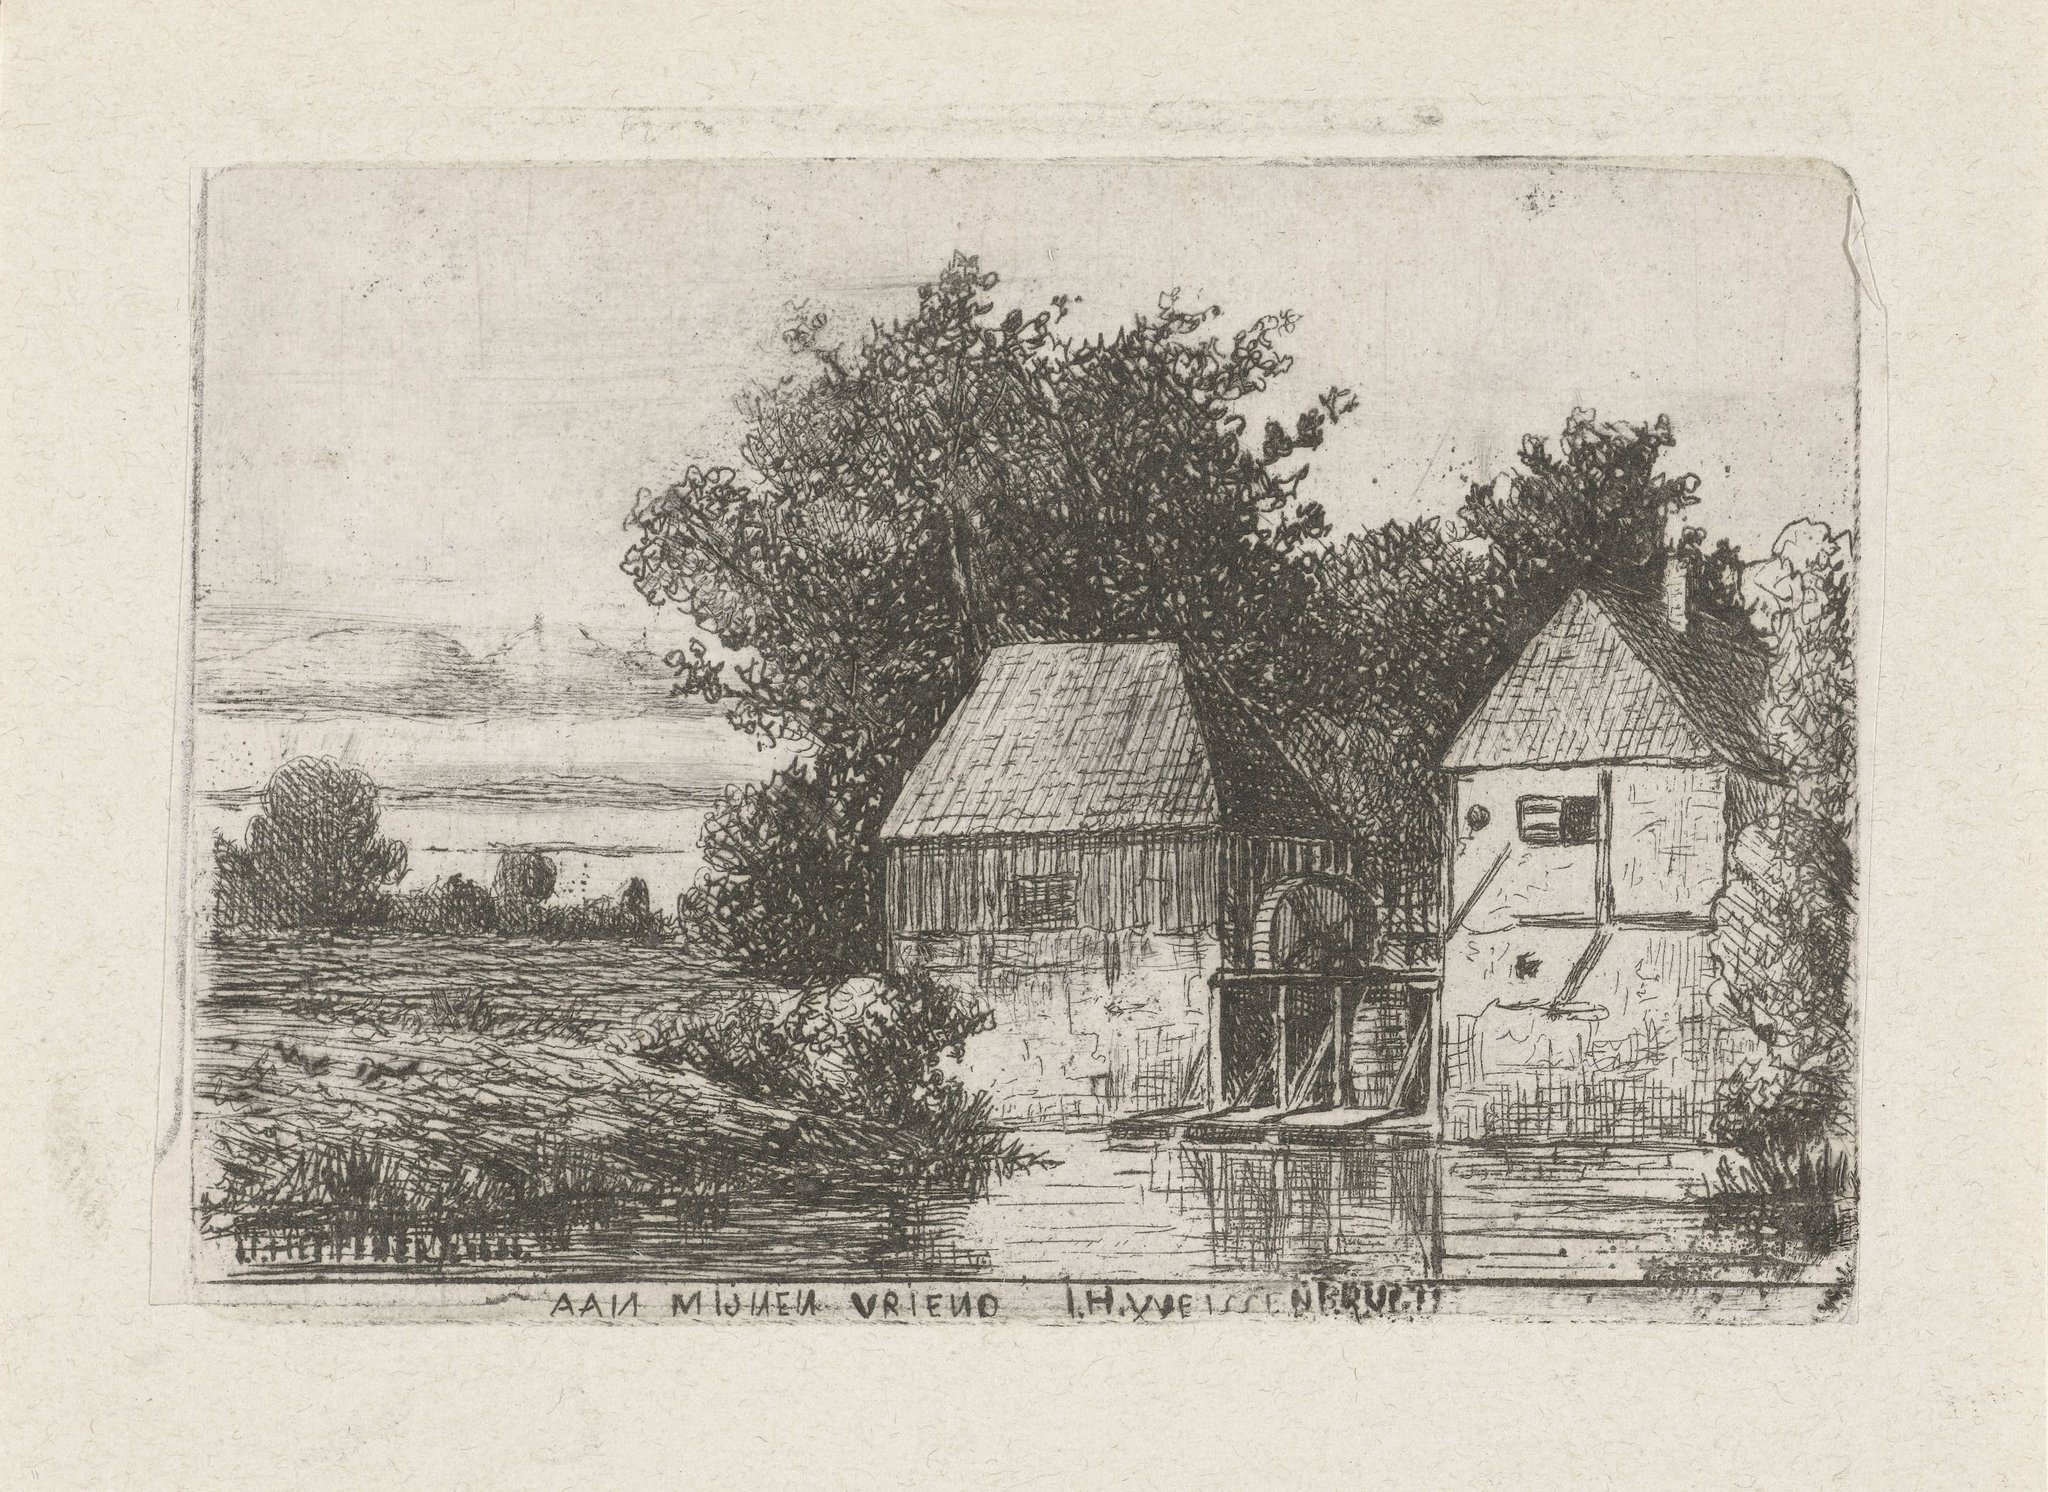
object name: print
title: Landschap met watermolen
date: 1841-1898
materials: paper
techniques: drypoint, etching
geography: the hague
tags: watermill in landscape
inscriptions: collector's mark: Lugt 2228